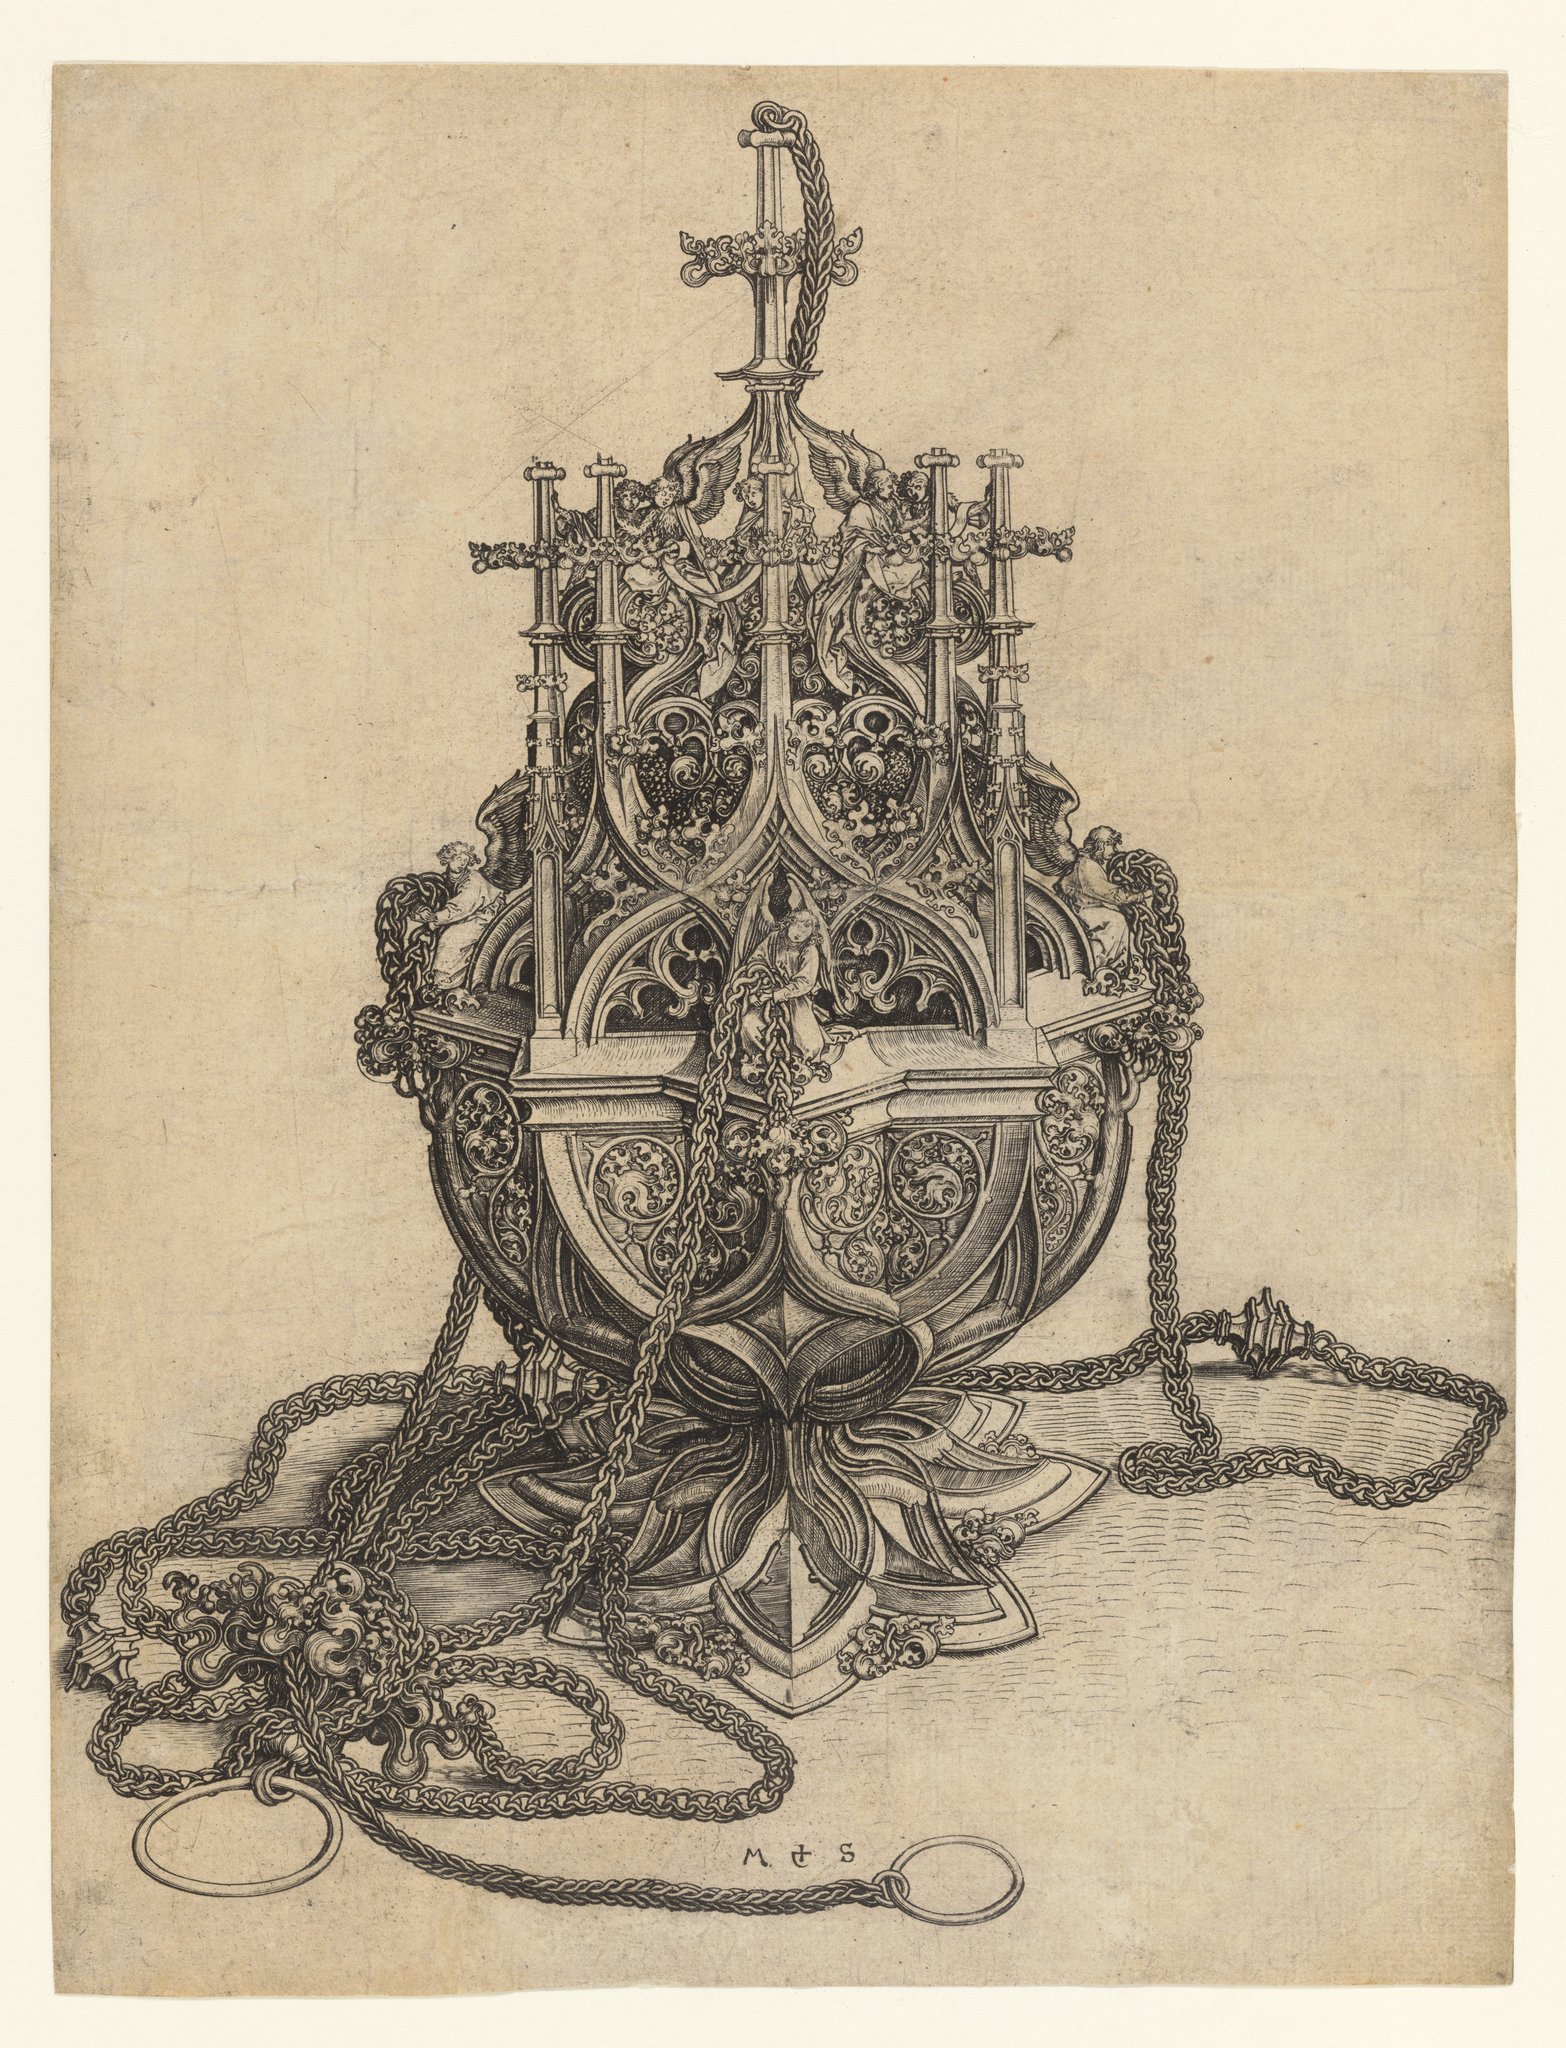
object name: print ornament architecture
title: The Censer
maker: martin schongauer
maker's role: artist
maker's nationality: german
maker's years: 1430-1491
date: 1470-1491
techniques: engraving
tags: censers